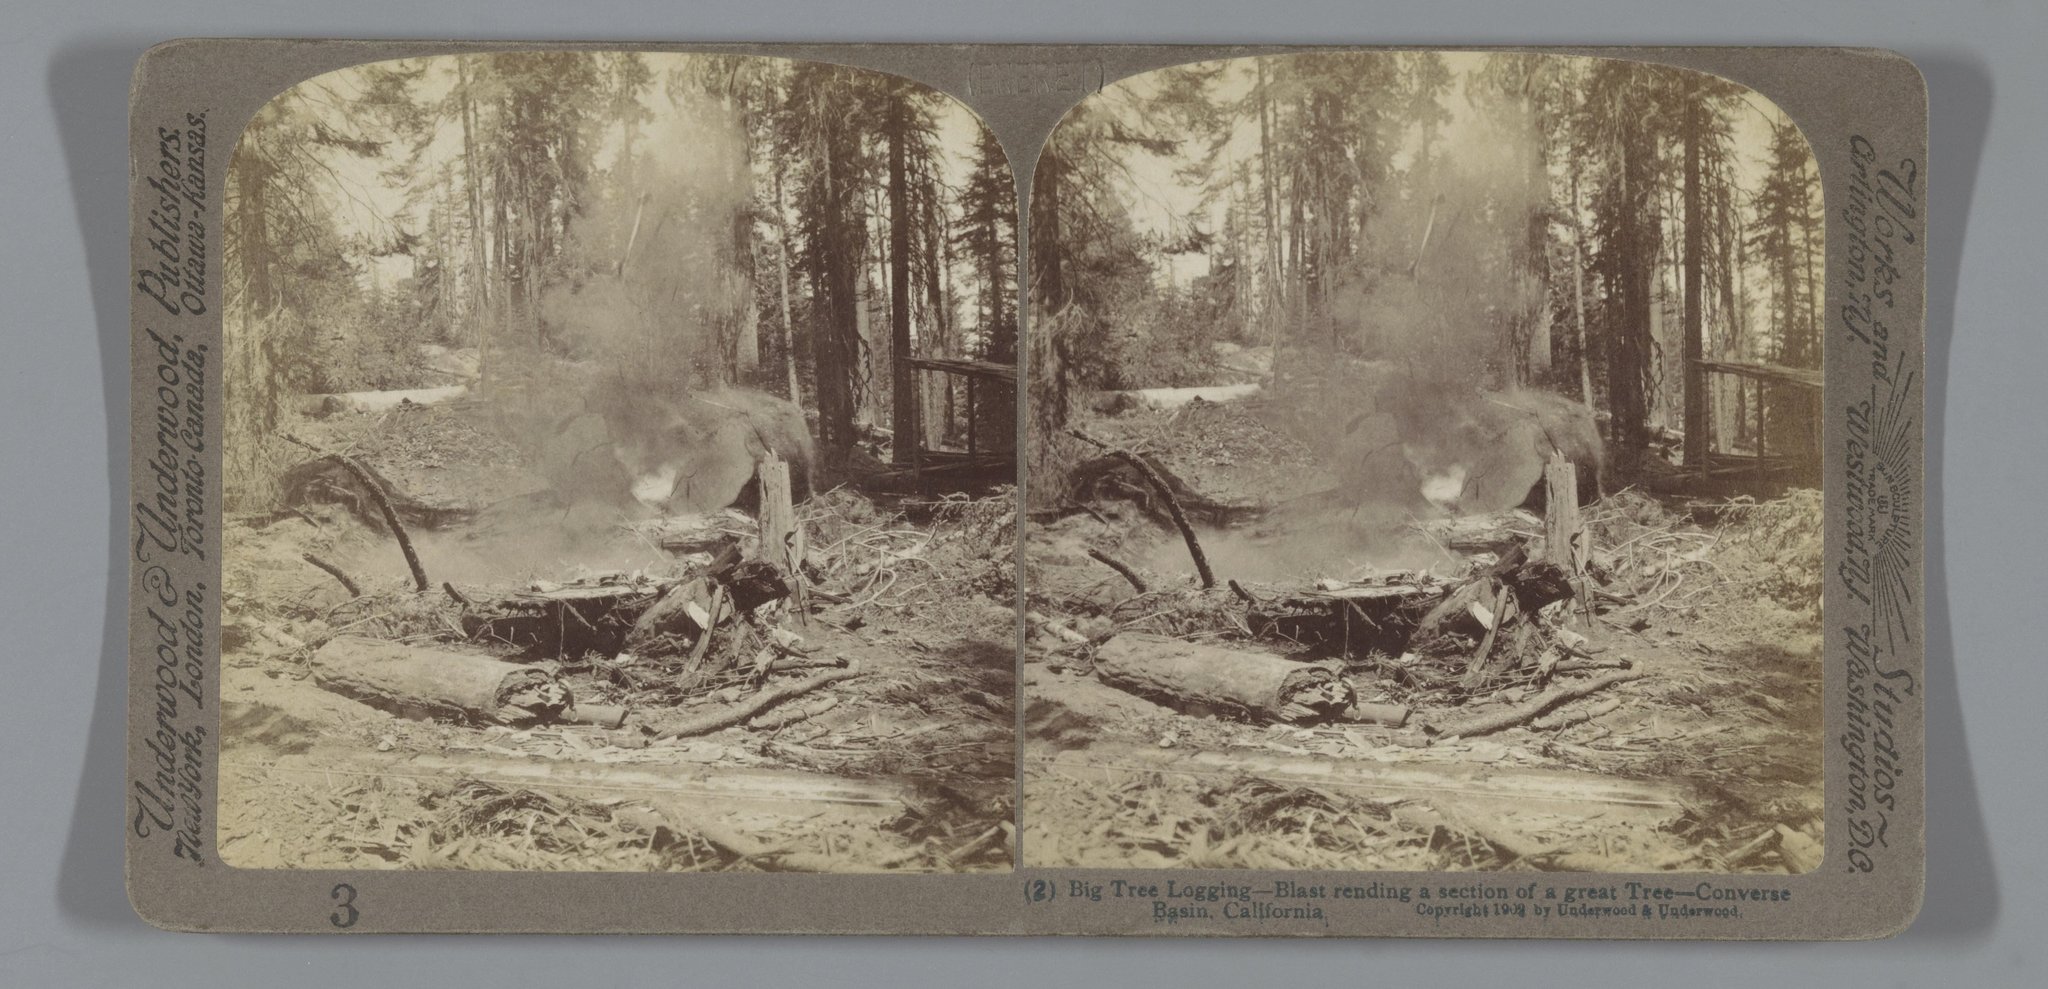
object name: stereograph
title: Big Tree Logging-Blast rending a section of a great Tree-Converse Basin, California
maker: Anonymous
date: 1902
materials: cardboard, paper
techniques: albumen print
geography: new york city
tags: beam, log of wood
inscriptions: copyright notice: ‘Copyright 1902 by Underwood & Underwood.’, number: ‘3’, inscription: ‘(See No. 1 of this series for the beginning of/ this dramatic piece of woodcraft.)/ The crash of the explosion is a mighty one./ You can see chips, splinters (...)’, title: ‘Big Tree Logging. Blast Rending the Tree. California.’, number: ‘2’, check stamp: ‘(ENERET)’, inscription: ‘SUN SCULPTURE/ UU/ TRADEMARK/ Works and Studios/ Arlington, N.J. Westwood, N.J. Washington, D.C.’, number: ‘P. 59.’